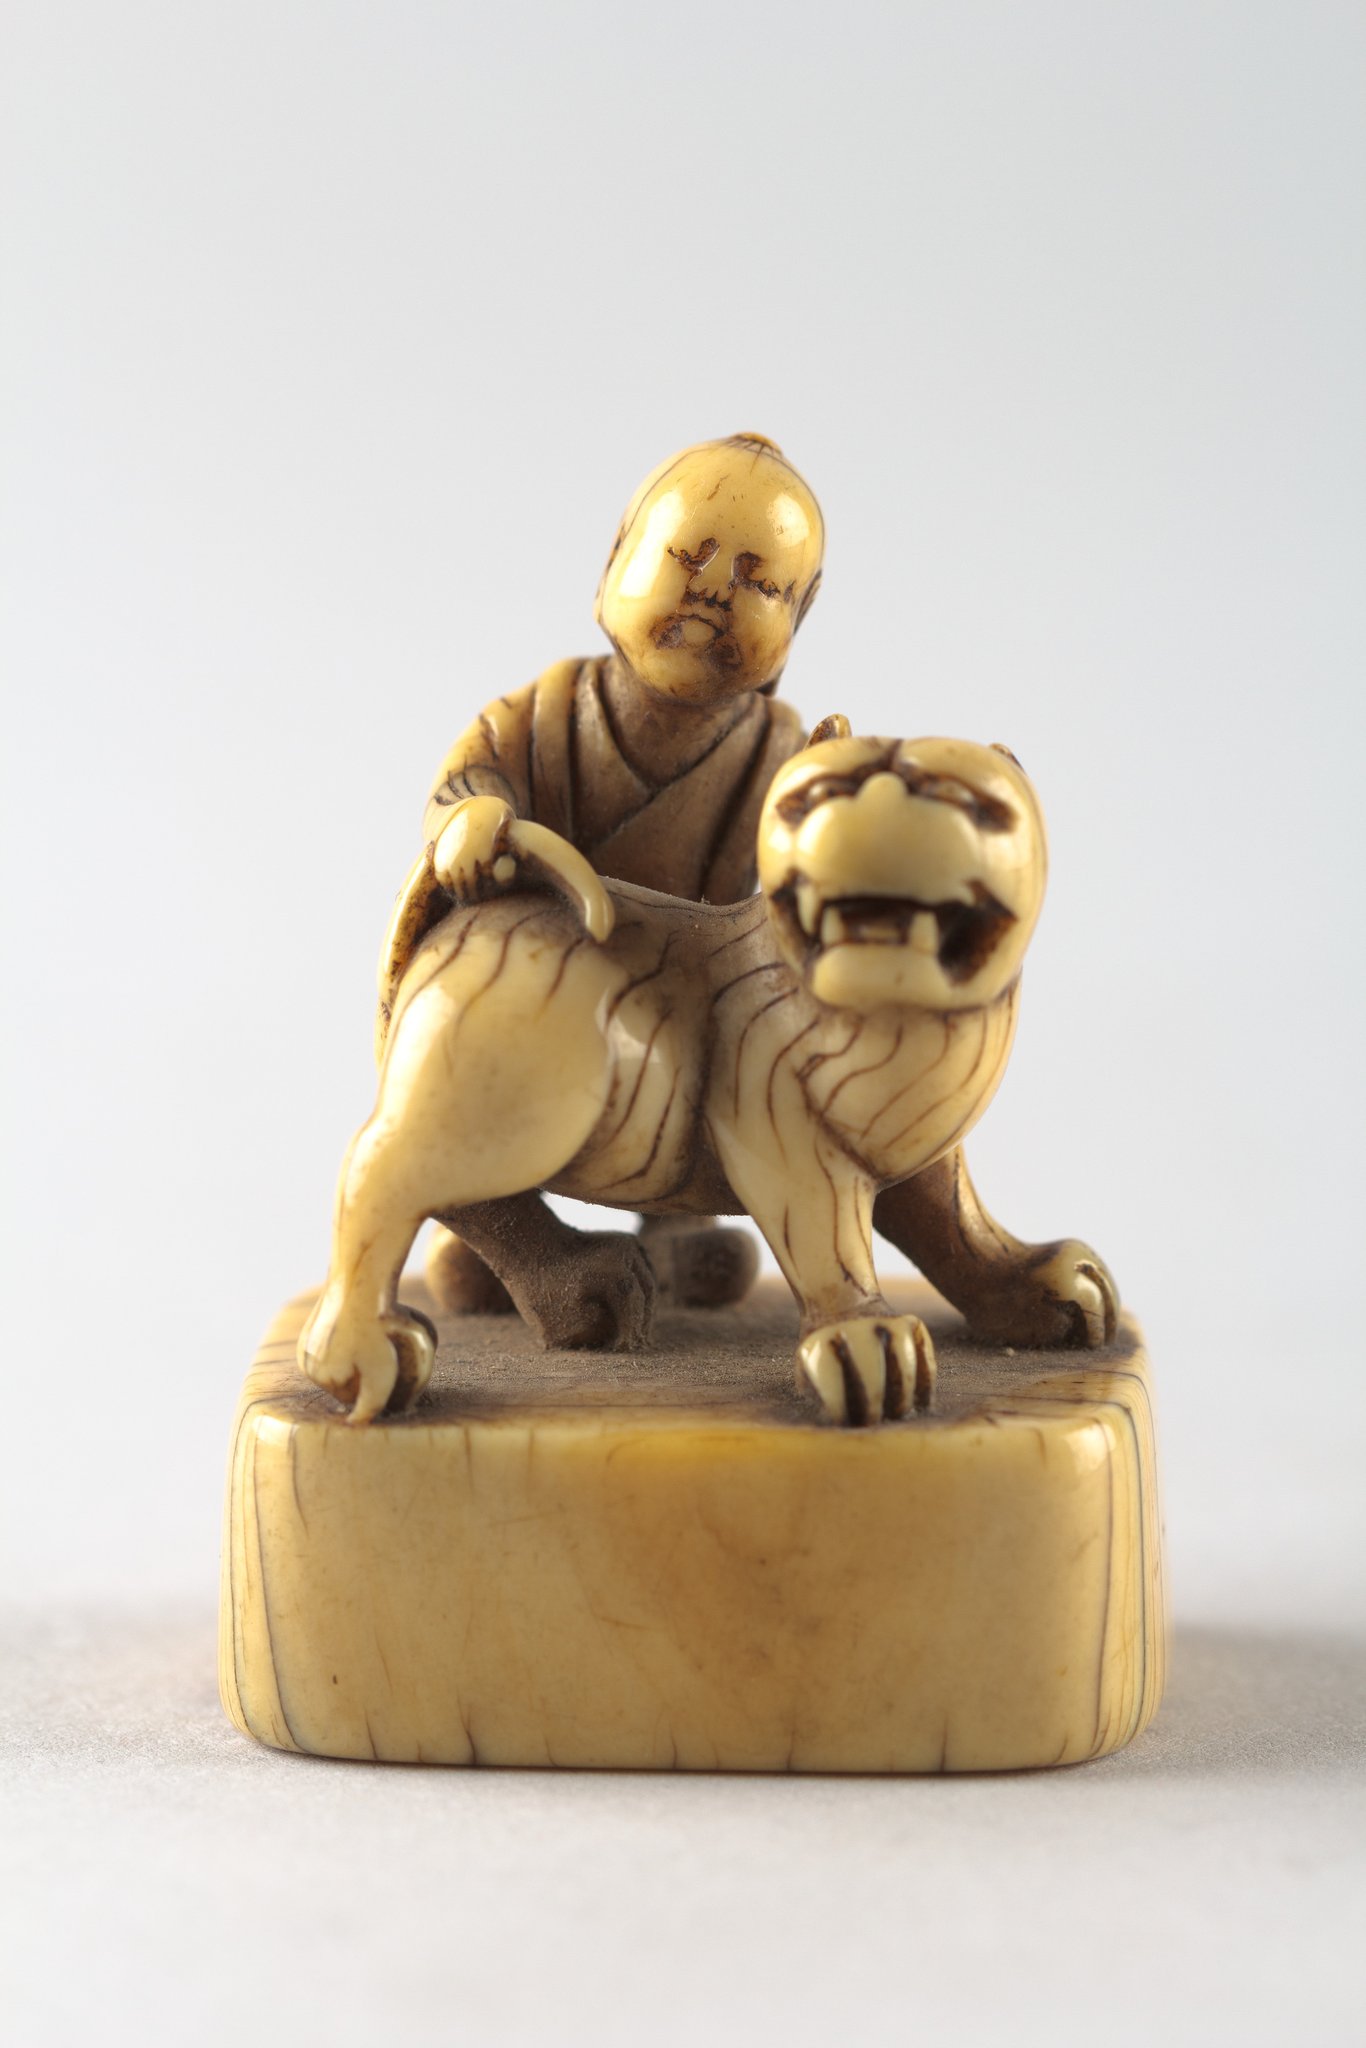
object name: netsuke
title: Netsuke of Boy with Dog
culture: japanese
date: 1801-1900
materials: ivory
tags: dogs